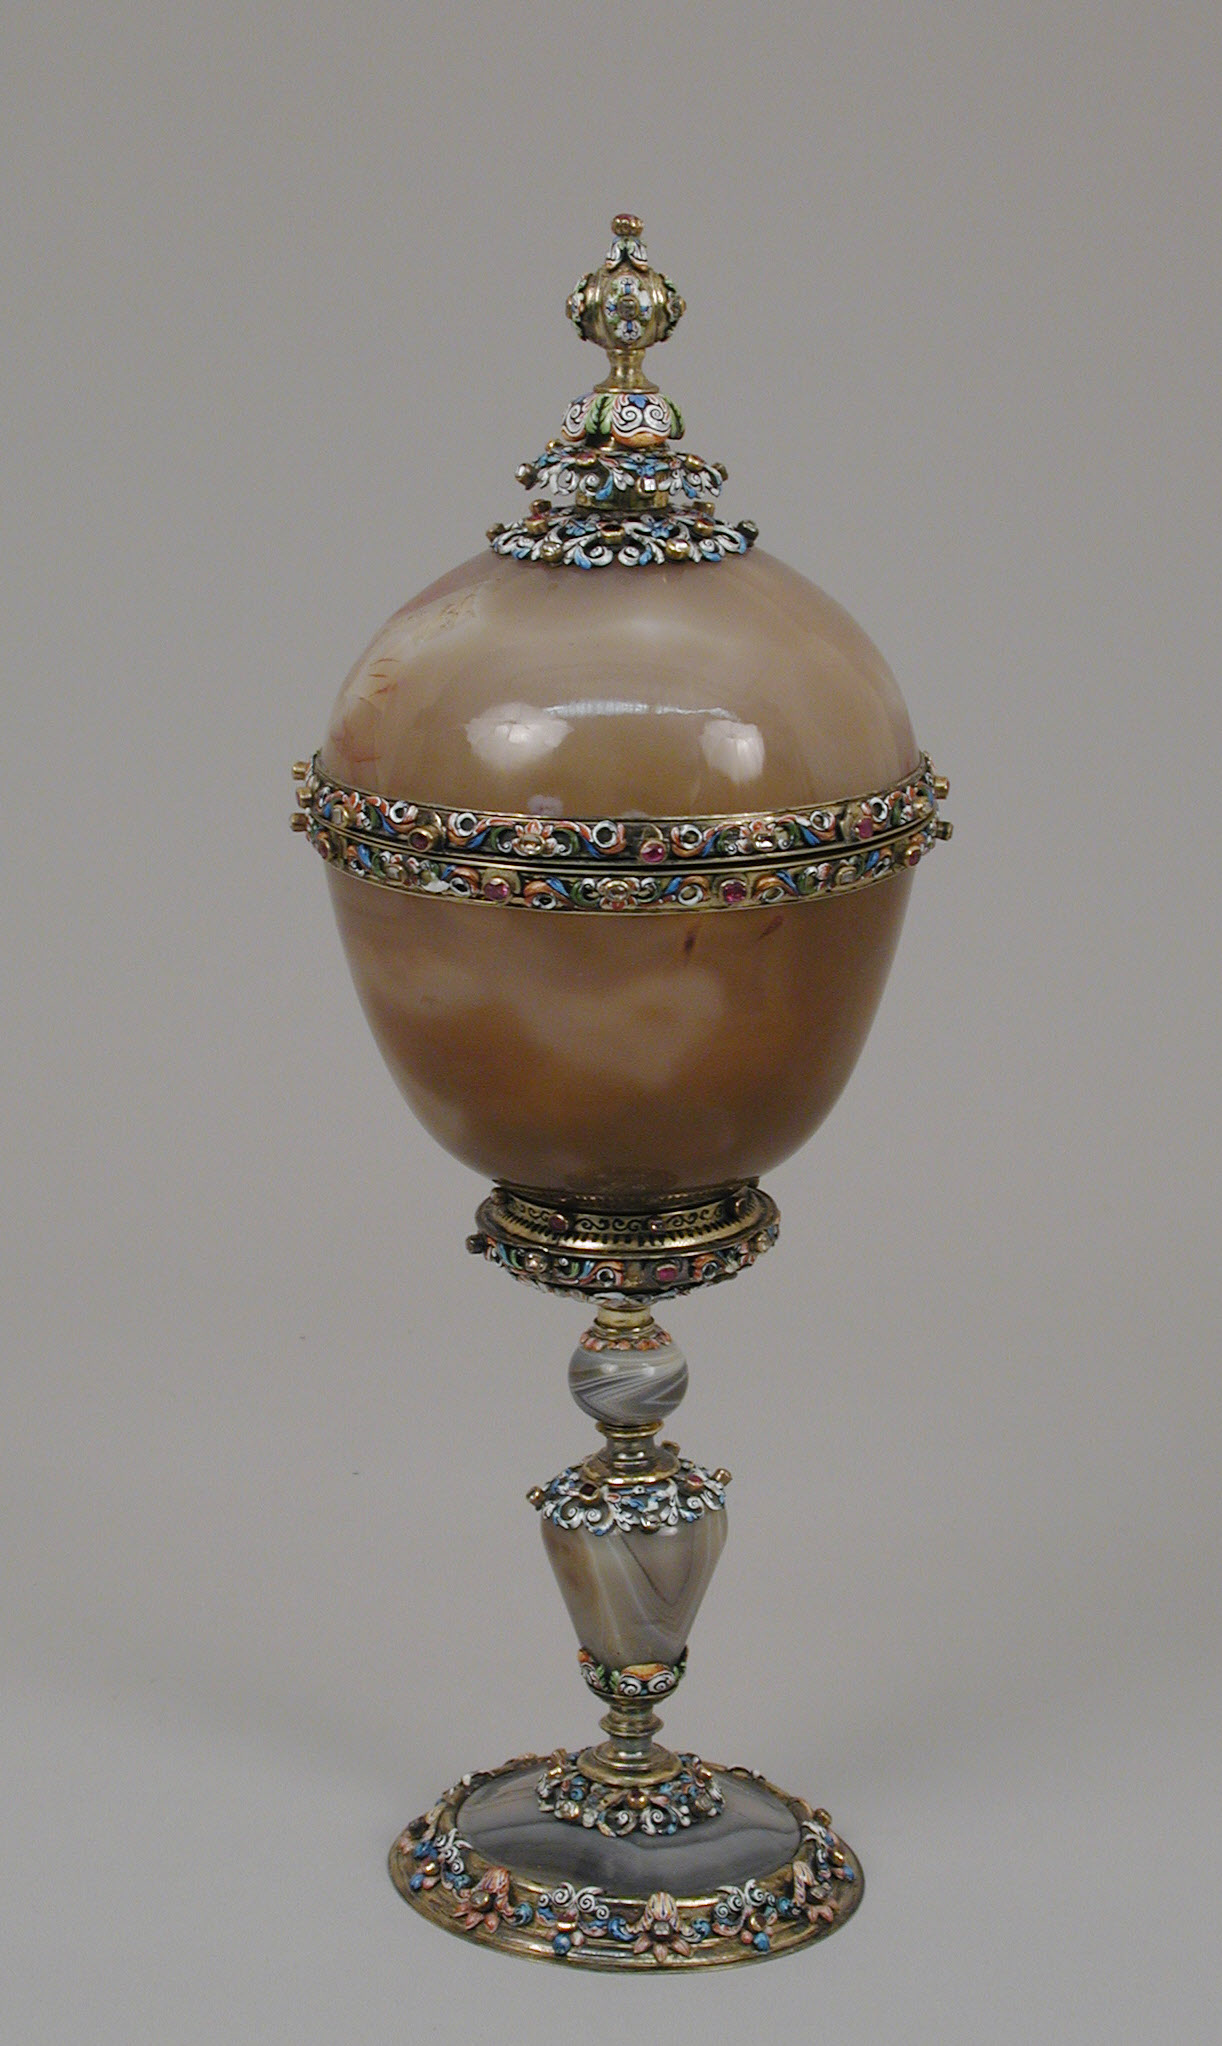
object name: cup with cover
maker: jeremias sibenbürger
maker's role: maker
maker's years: 1583-1659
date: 1650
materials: stone, diamond, enamel, gemstone, silver gilt